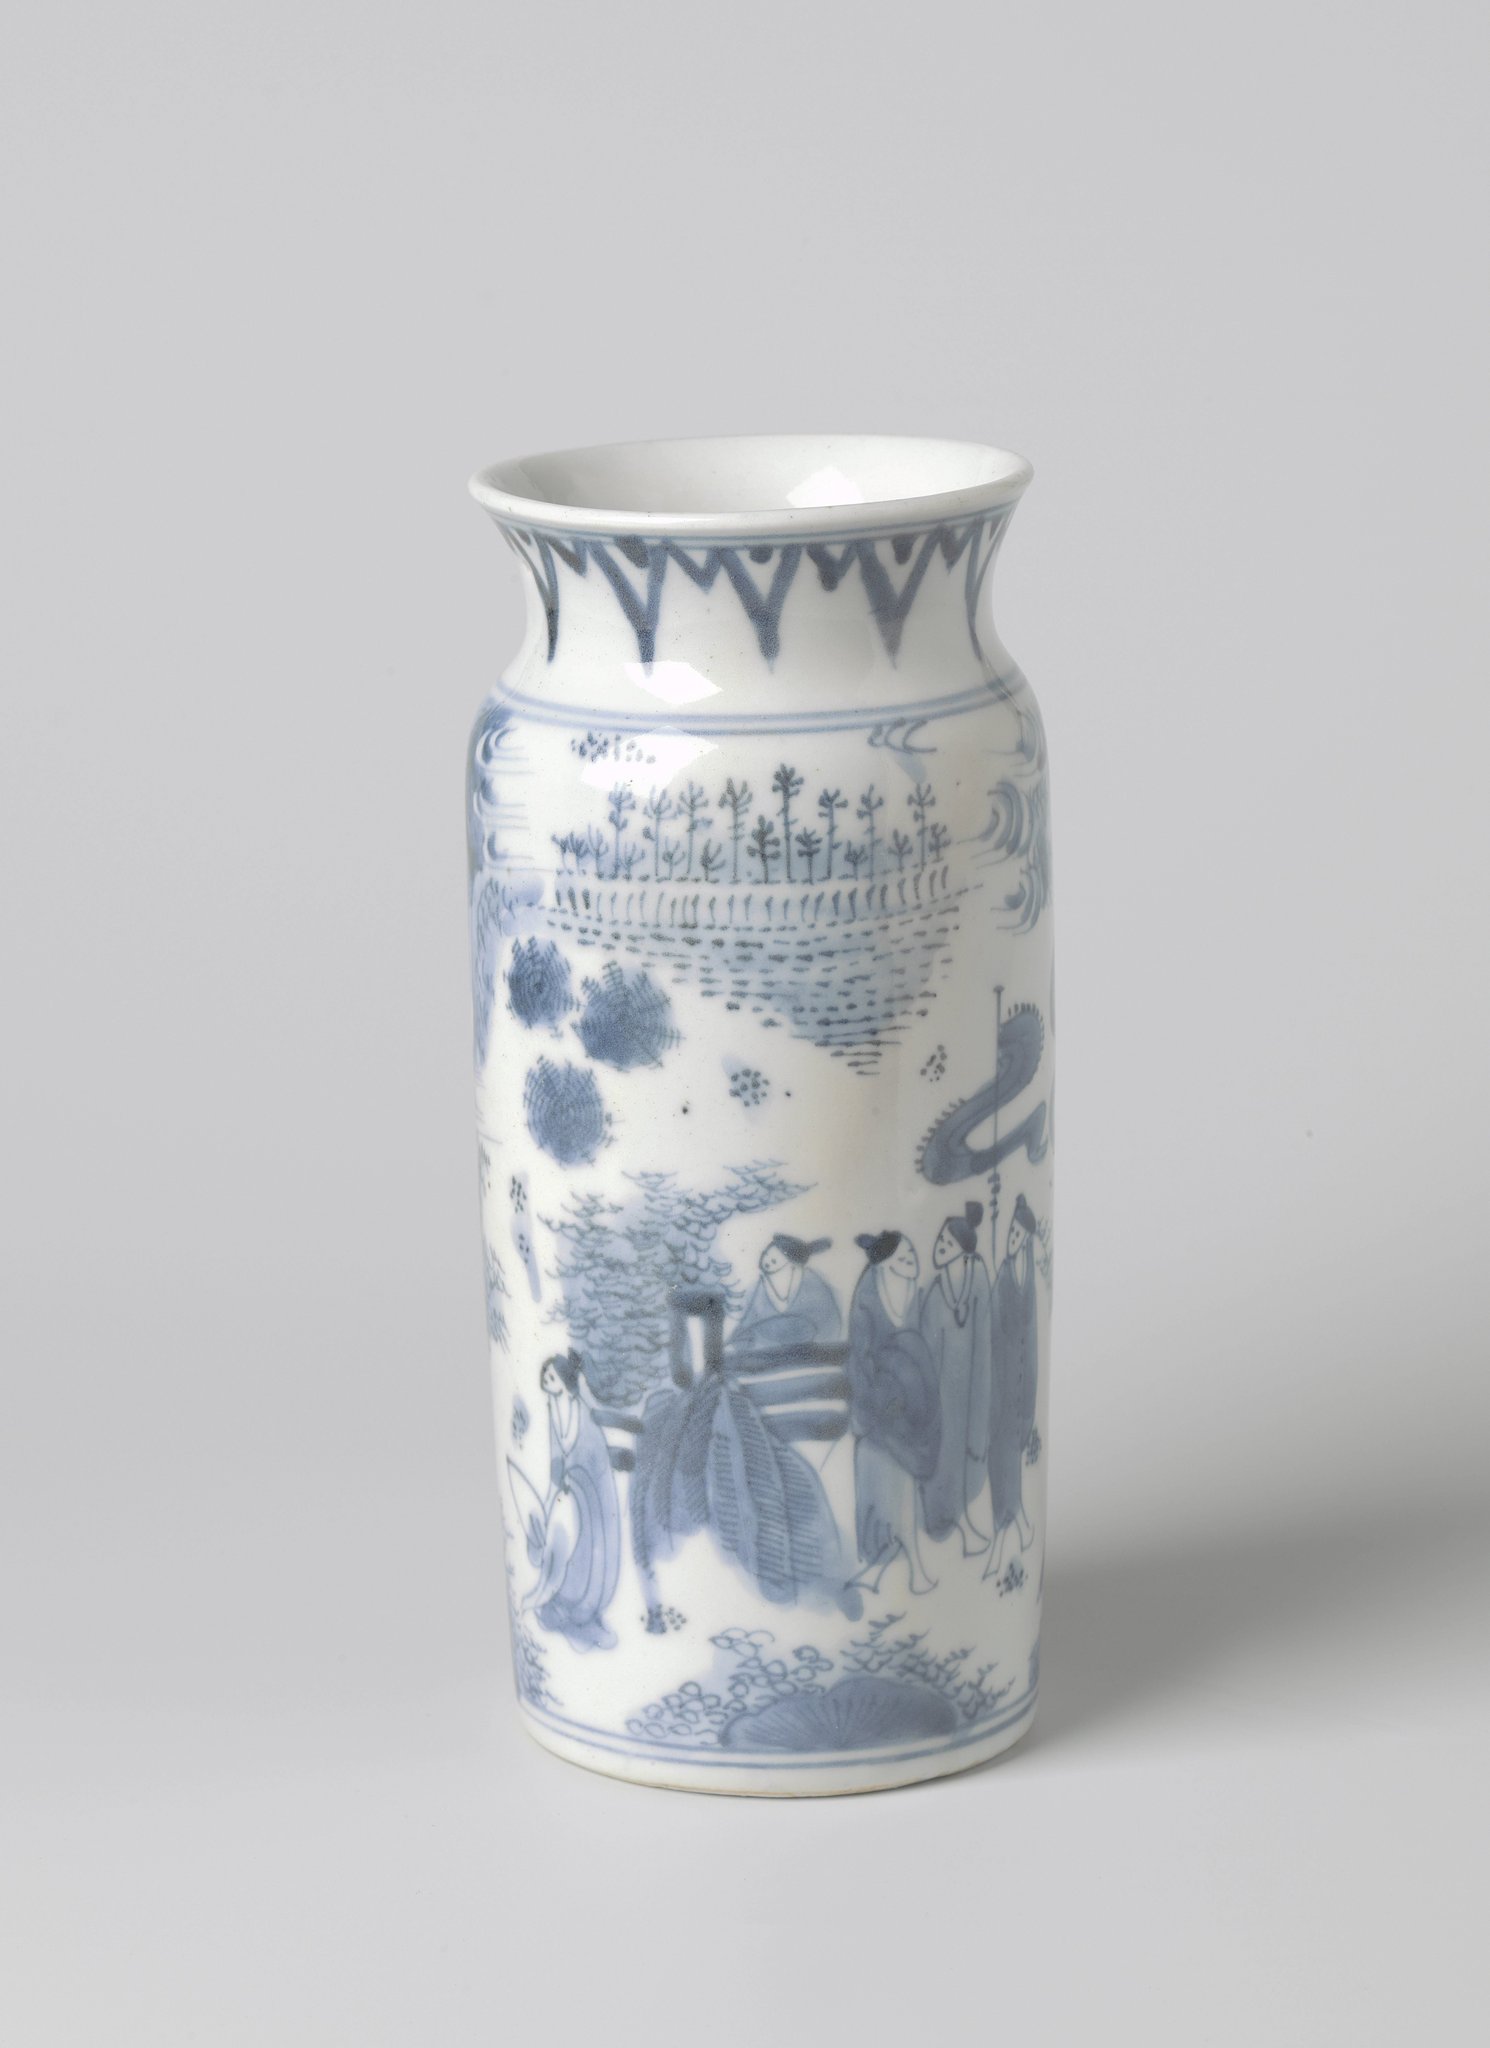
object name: vase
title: Cilindrical vase with a continuous image with figures in a landscape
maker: Anonymous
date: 1650-1680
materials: cobalt, glaze, paint, porcelain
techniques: firing, turning, vitrification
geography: arita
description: Rolwagen. China, 1660-1680. Chinese and Japanese porcelain decorated in underglaze blue.